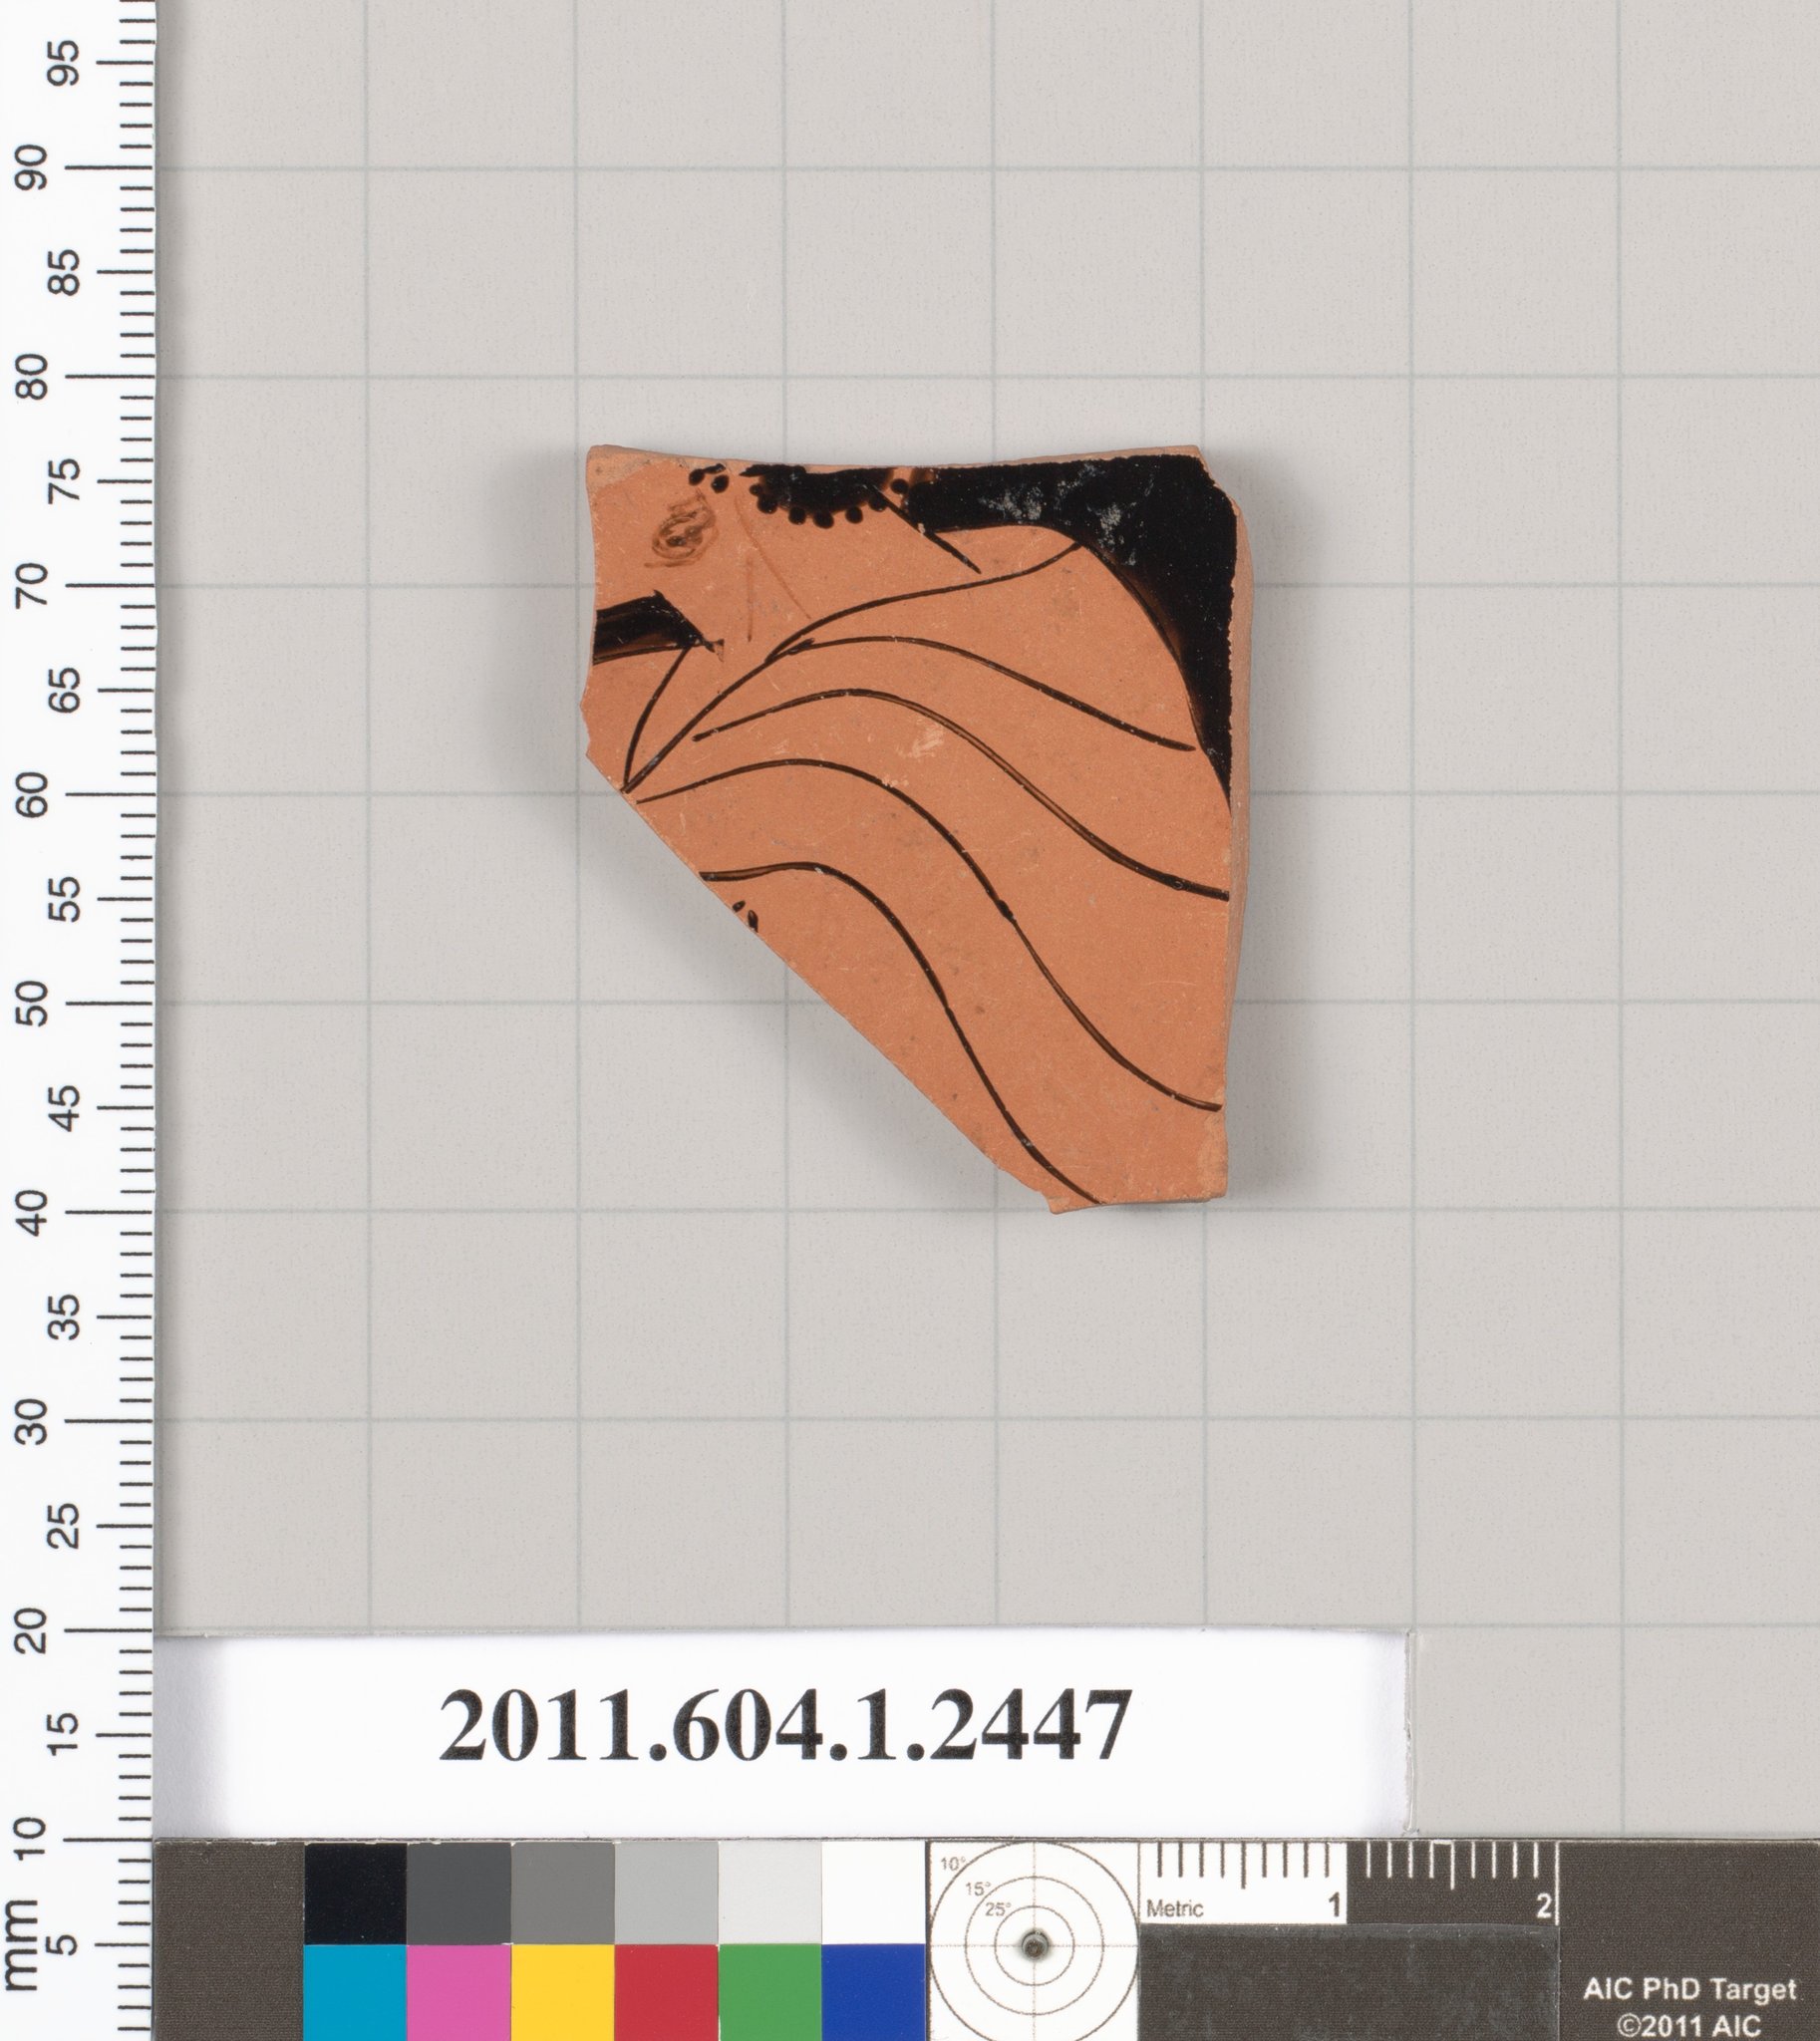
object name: kylix fragment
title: Terracotta fragment of a kylix (drinking cup)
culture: greek, attic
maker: ambrosios painter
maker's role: artist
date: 520-500 BCE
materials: terracotta